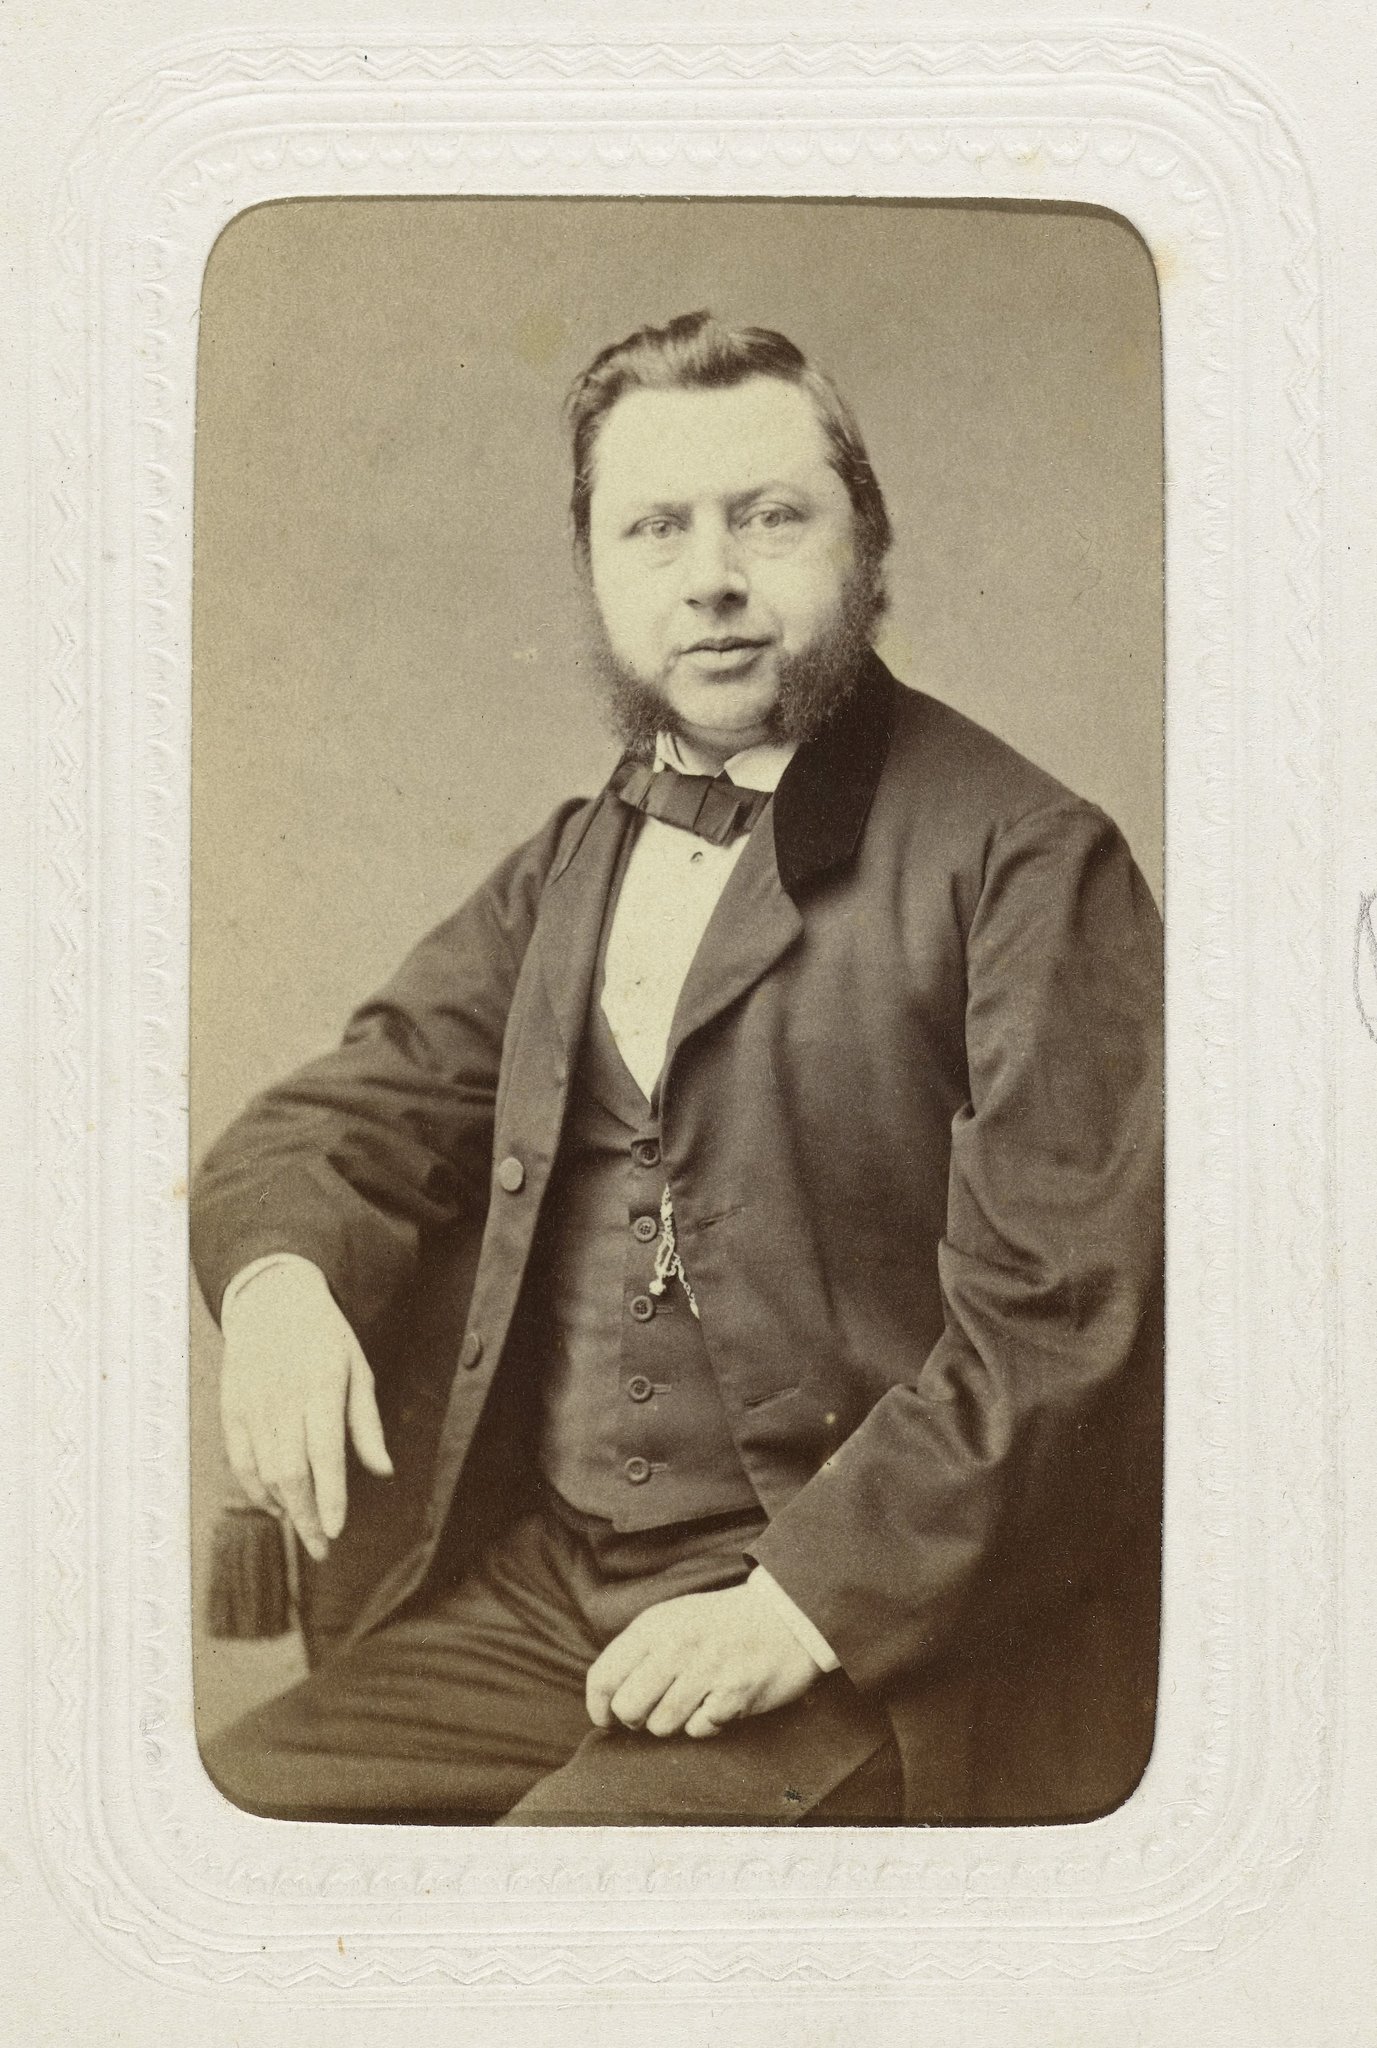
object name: carte de visite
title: Studioportret van een man op een stoel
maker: franz wilhelm deutmann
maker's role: fotograaf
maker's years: 1809-1895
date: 1863-1866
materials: cardboard, paper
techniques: albumen print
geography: amsterdam